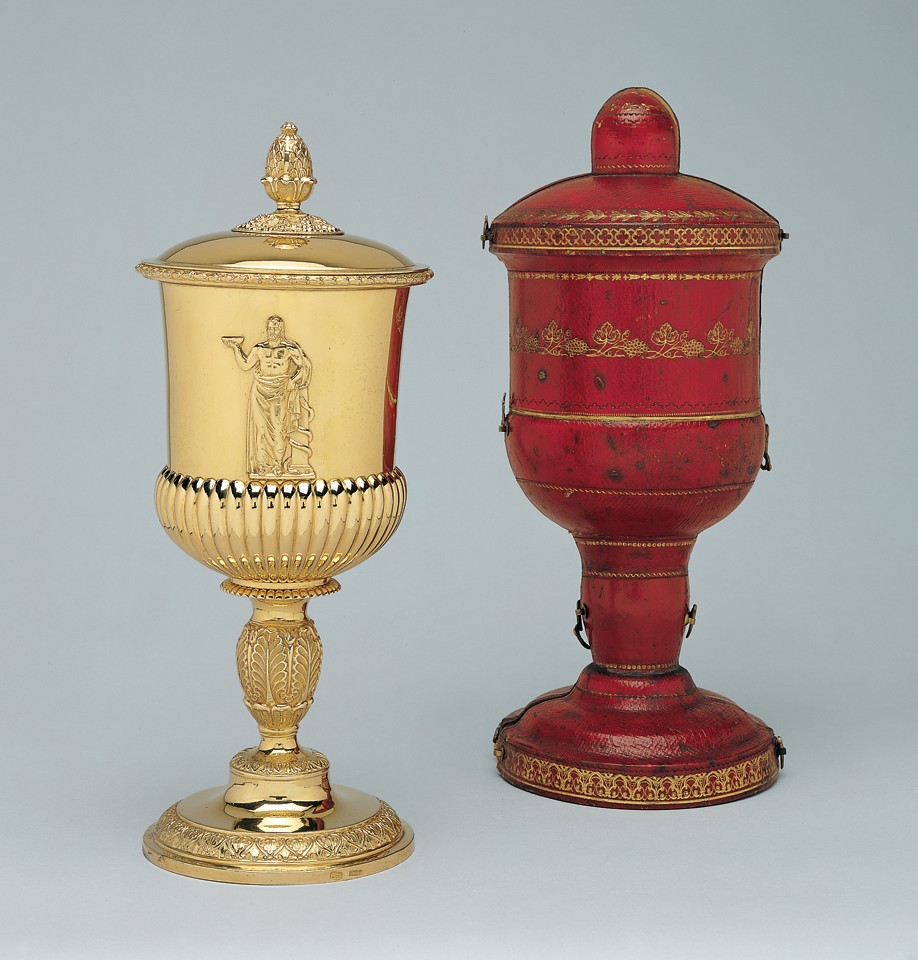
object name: cup with cover and case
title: Cup with cover with a leather case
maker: franz hubert doreck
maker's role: maker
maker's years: 1766-1866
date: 1822-1830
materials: leather, silver gilt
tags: human figures